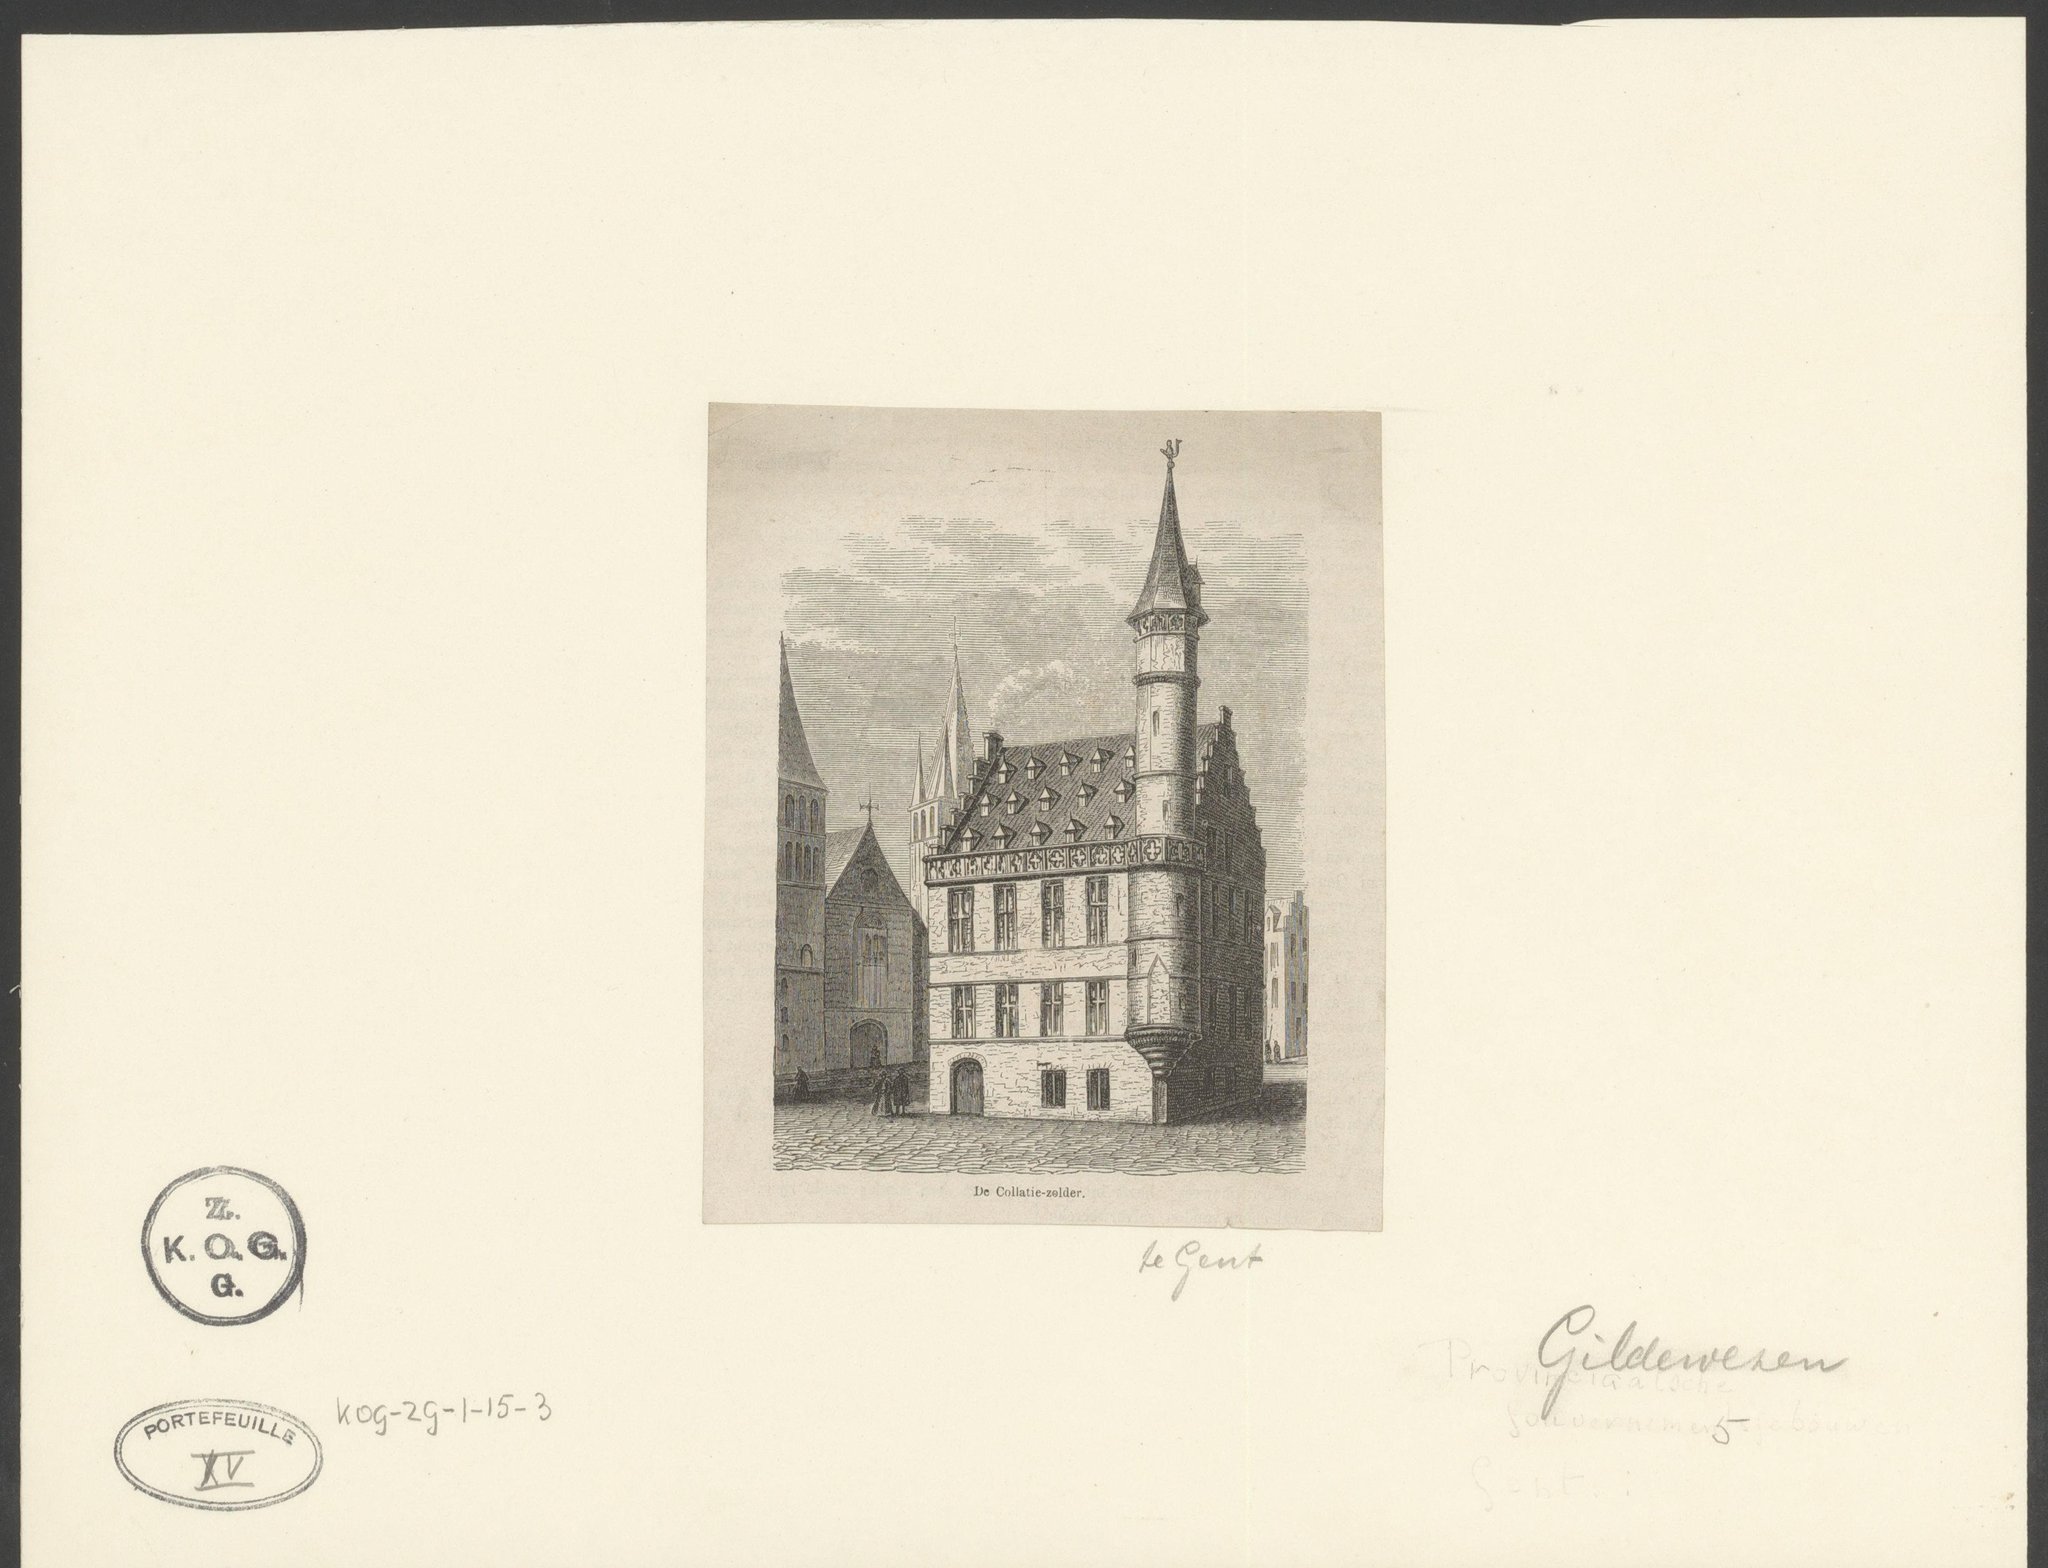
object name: print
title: De Collatie-zolder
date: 1869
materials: paper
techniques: letterpress printing, engraving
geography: haarlem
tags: guildhall, ghent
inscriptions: collector's mark: Lugt 1641, stamp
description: Het Toreken op de Vrijdagmarkt in Gent. Het Toreken heeft tot 1540 dienstgedaan als ambachtshuis van het huidenvettersgilde. Onderwerpsrubrieken binnen de Atlas Zeden en Gewoonten: Handel, nijverheid en verkeer, Gildewezen.